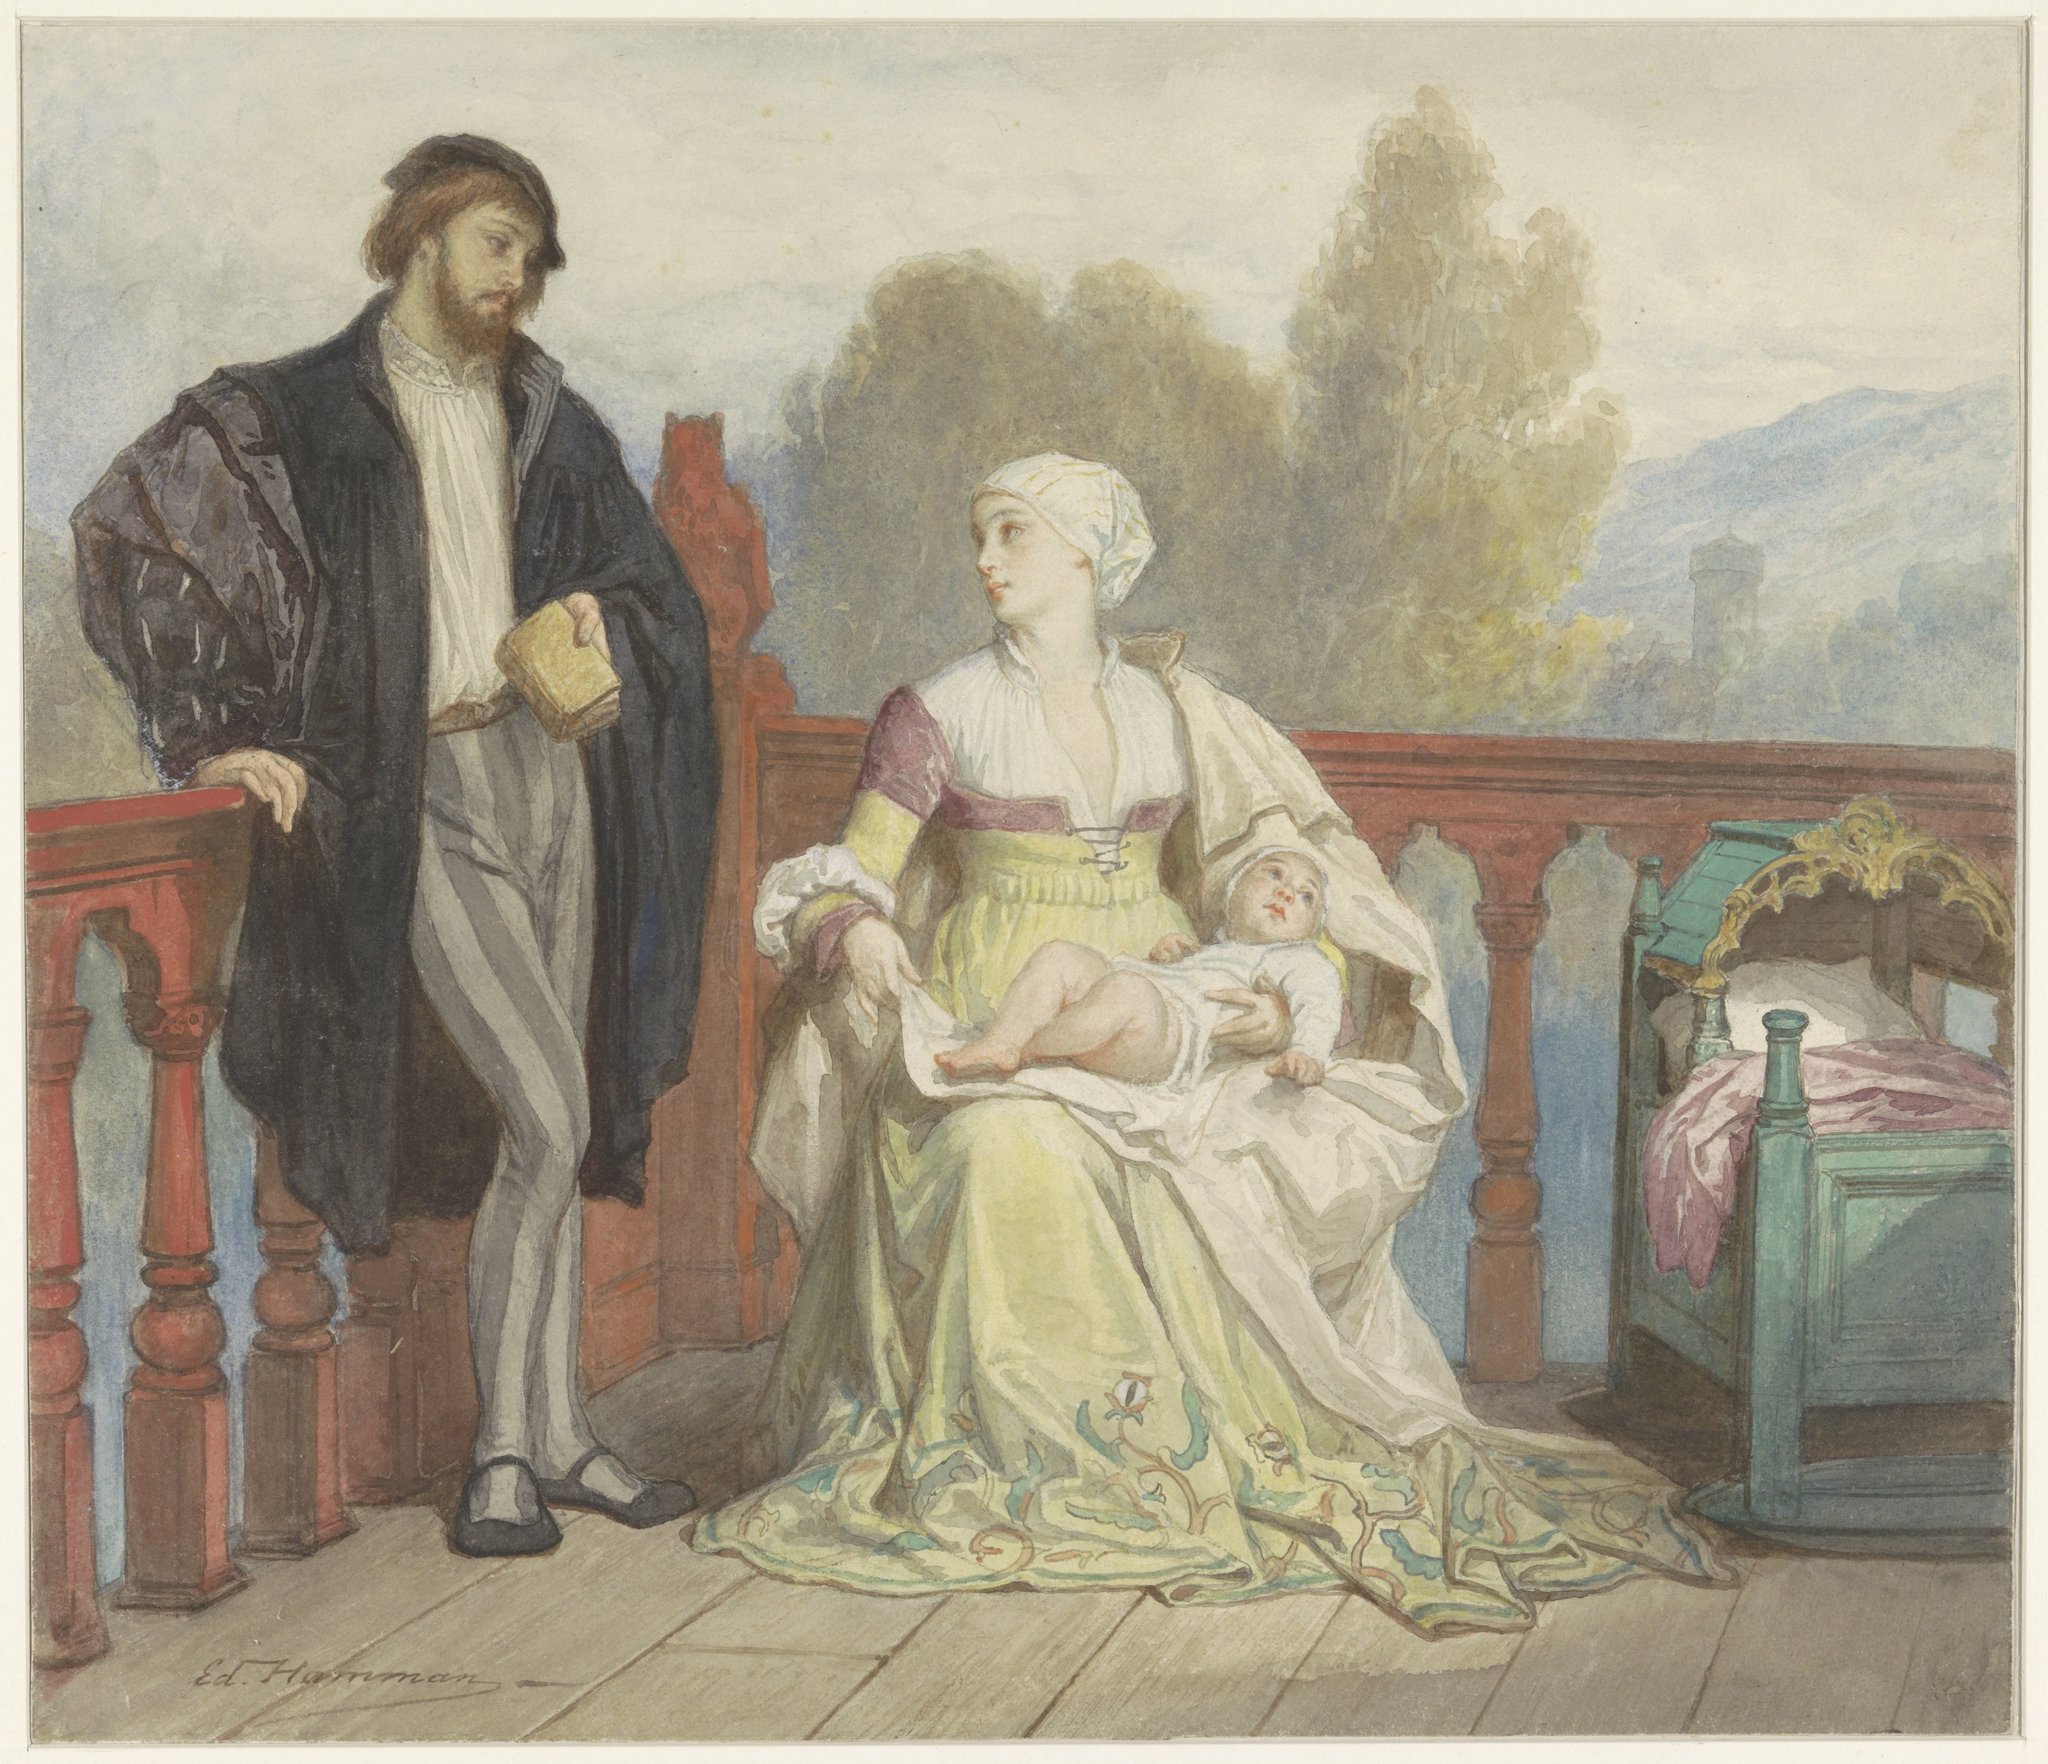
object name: drawing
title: Francesca di Rimini en Paolo di Polenta met kind op een balkon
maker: edouard hamman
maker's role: draughtsman, print maker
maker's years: 1819-1888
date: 1829-1888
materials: chalk, paper, watercolor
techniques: brush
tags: historical persons - bb - woman, family group, especially parents with their child(ren), historical persons